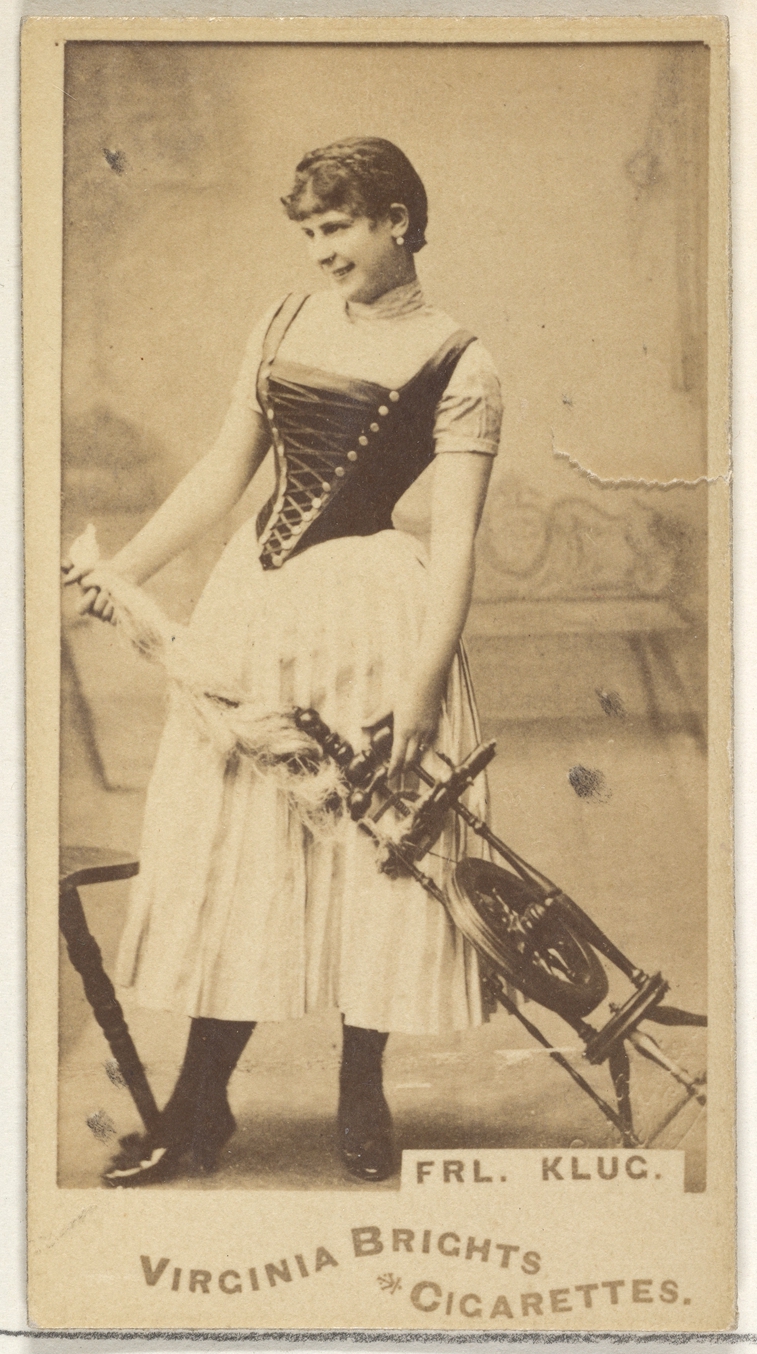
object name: photograph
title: Fräulein Klug, from the Actors and Actresses series (N45, Type 1) for Virginia Brights Cigarettes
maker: allen & ginter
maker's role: publisher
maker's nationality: american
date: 1888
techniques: albumen silver print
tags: portraits,women,actresses